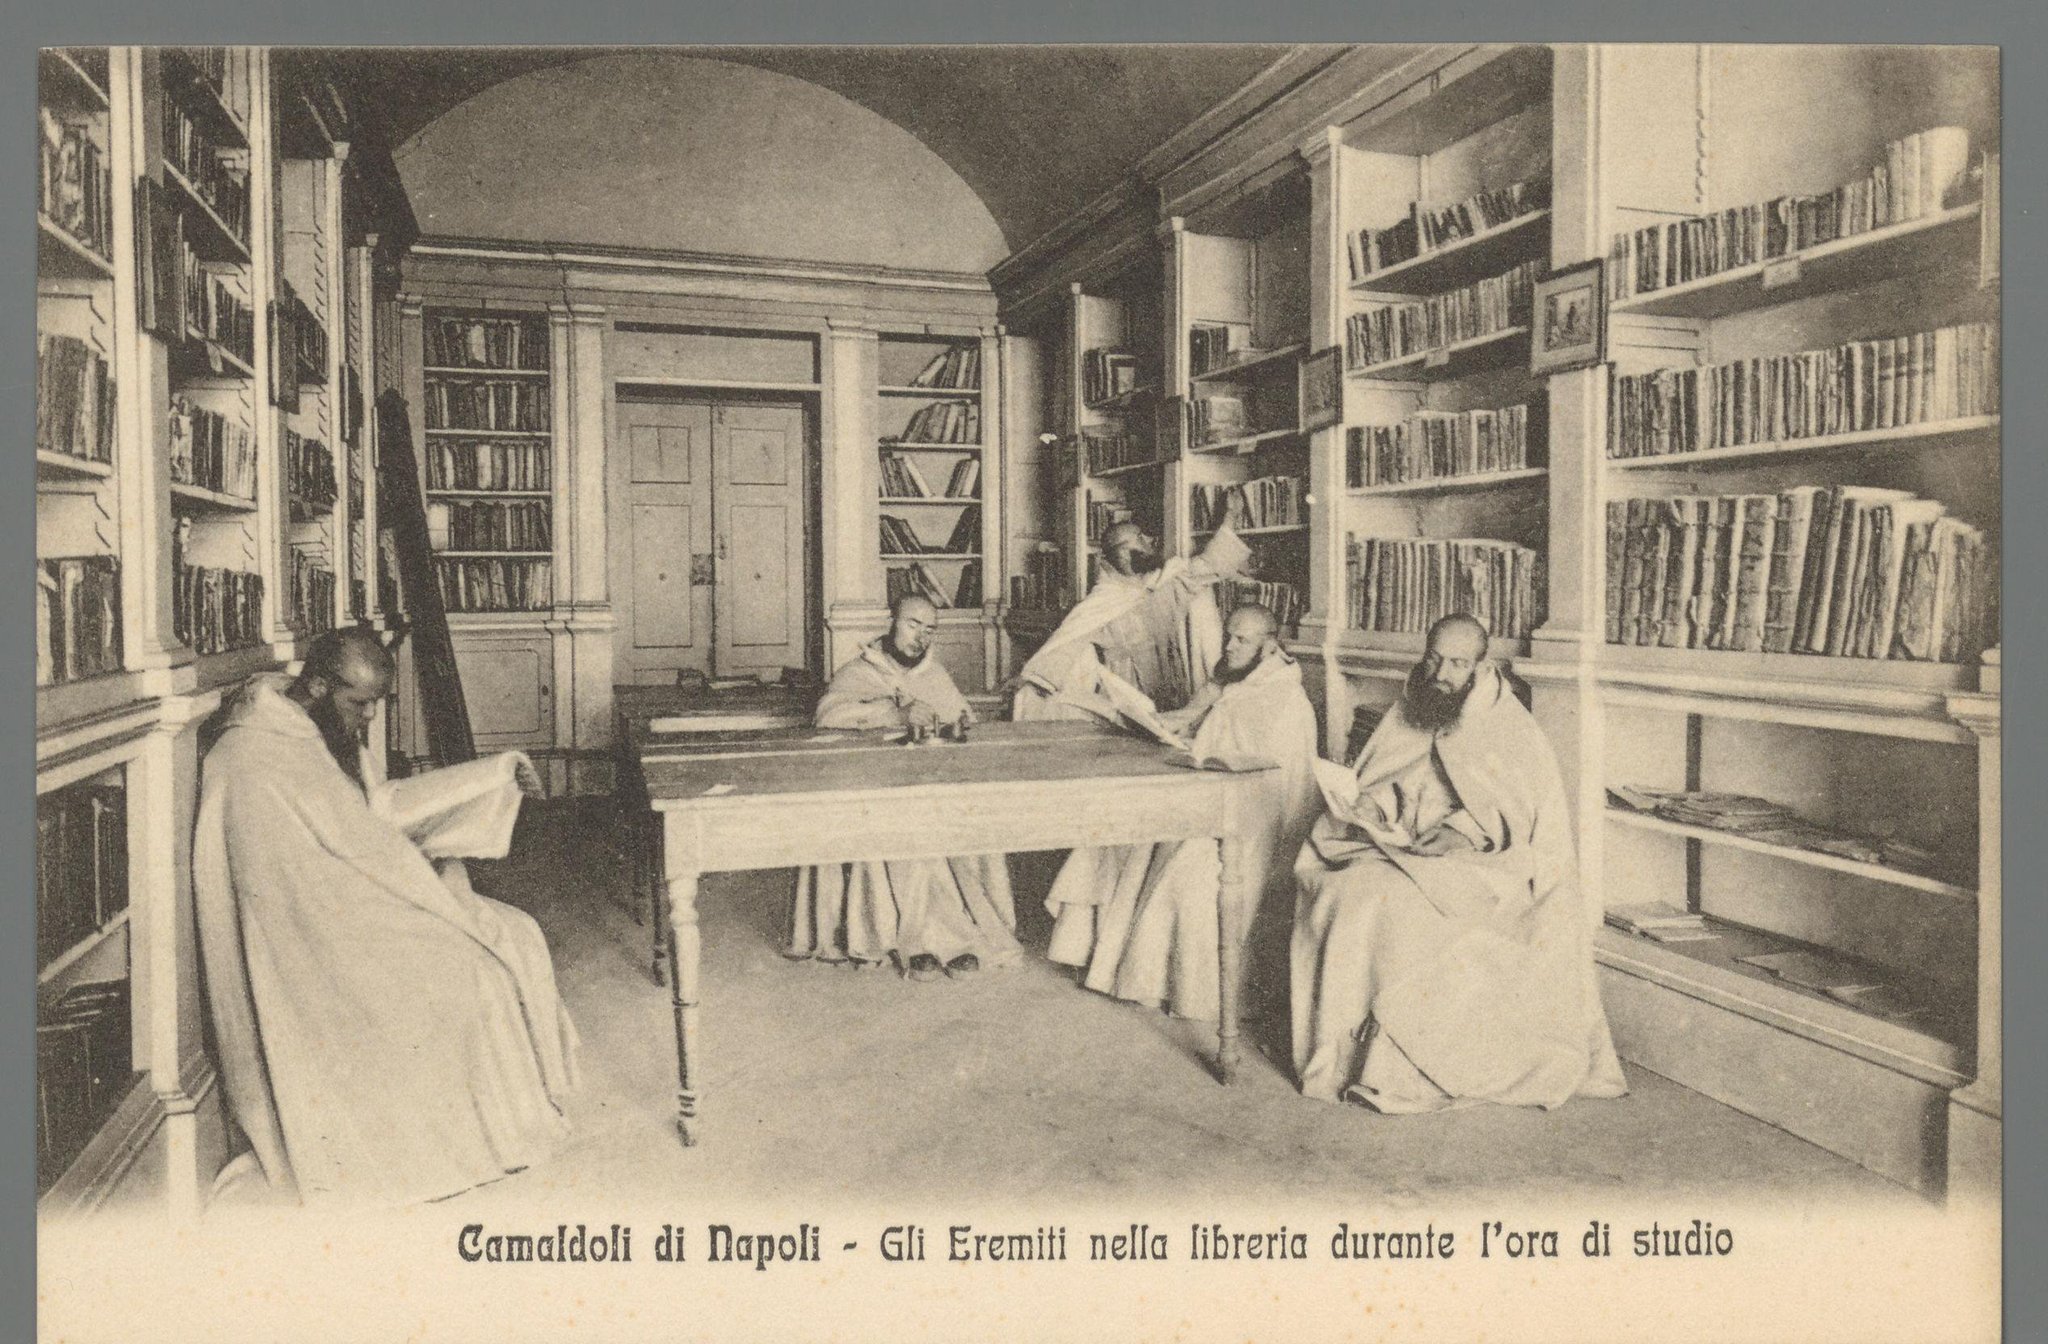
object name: ansichtkaart, prentbriefkaart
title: Camaldoli di Napoli. Gli Eremiti nella libreria durante l'ora di studio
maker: Anonymous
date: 1906-1910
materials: cardboard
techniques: photograph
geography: terni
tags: abbey, monastery, convent ~ roman catholic church, monk(s), friar(s), study; 'studiolo'; library, camaldoli